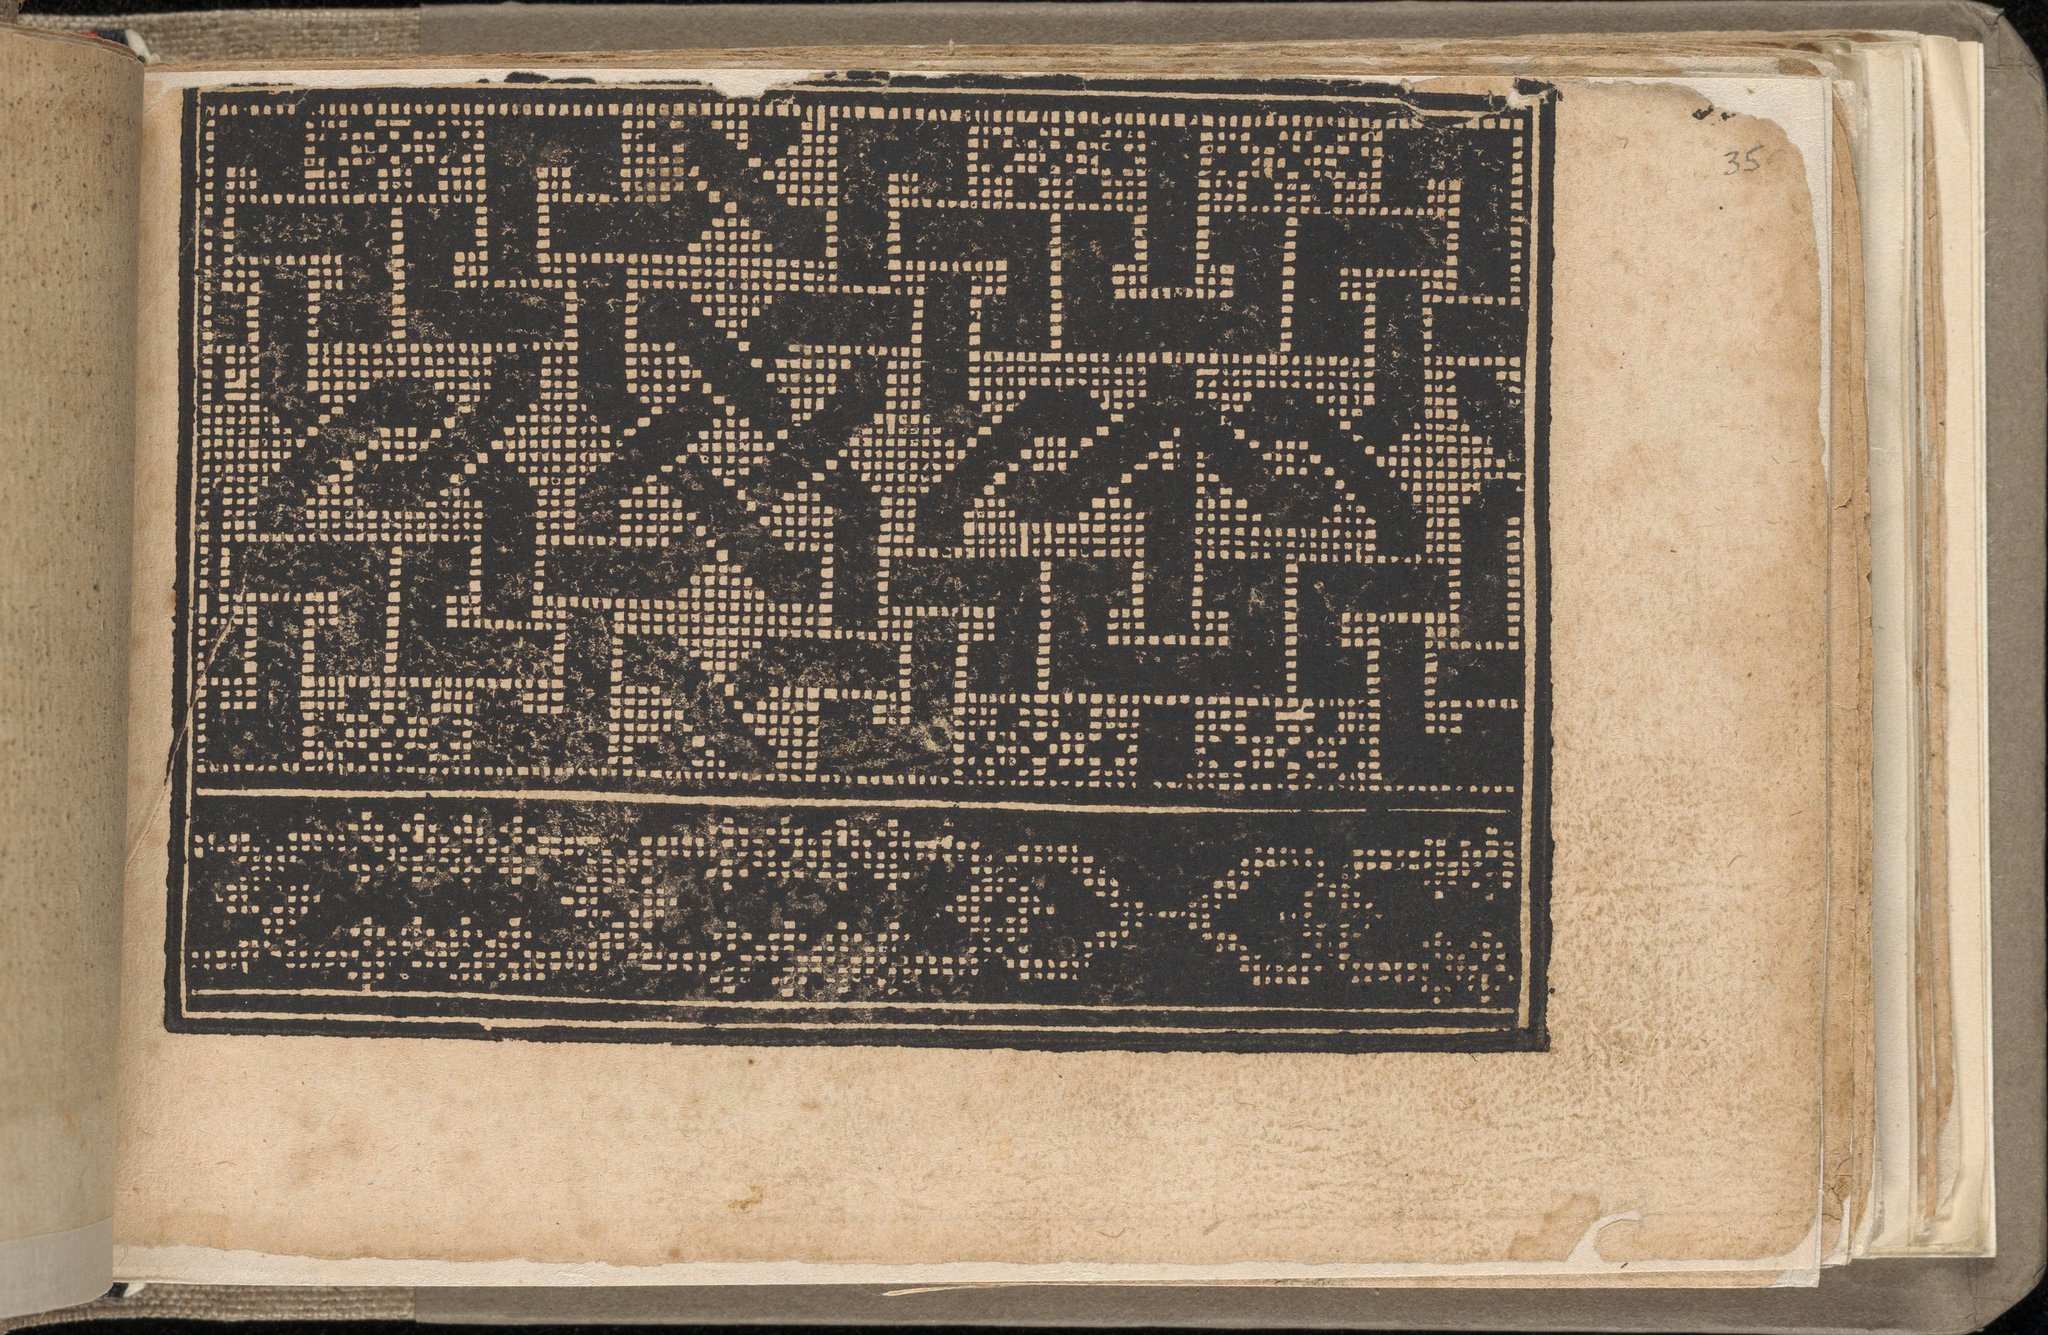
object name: book print ornament architecture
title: Schön newes Modelbuch (Page 35r)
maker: sigismundus latomus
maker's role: publisher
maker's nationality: german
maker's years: 1599-1632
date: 1608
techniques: woodcut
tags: ornament